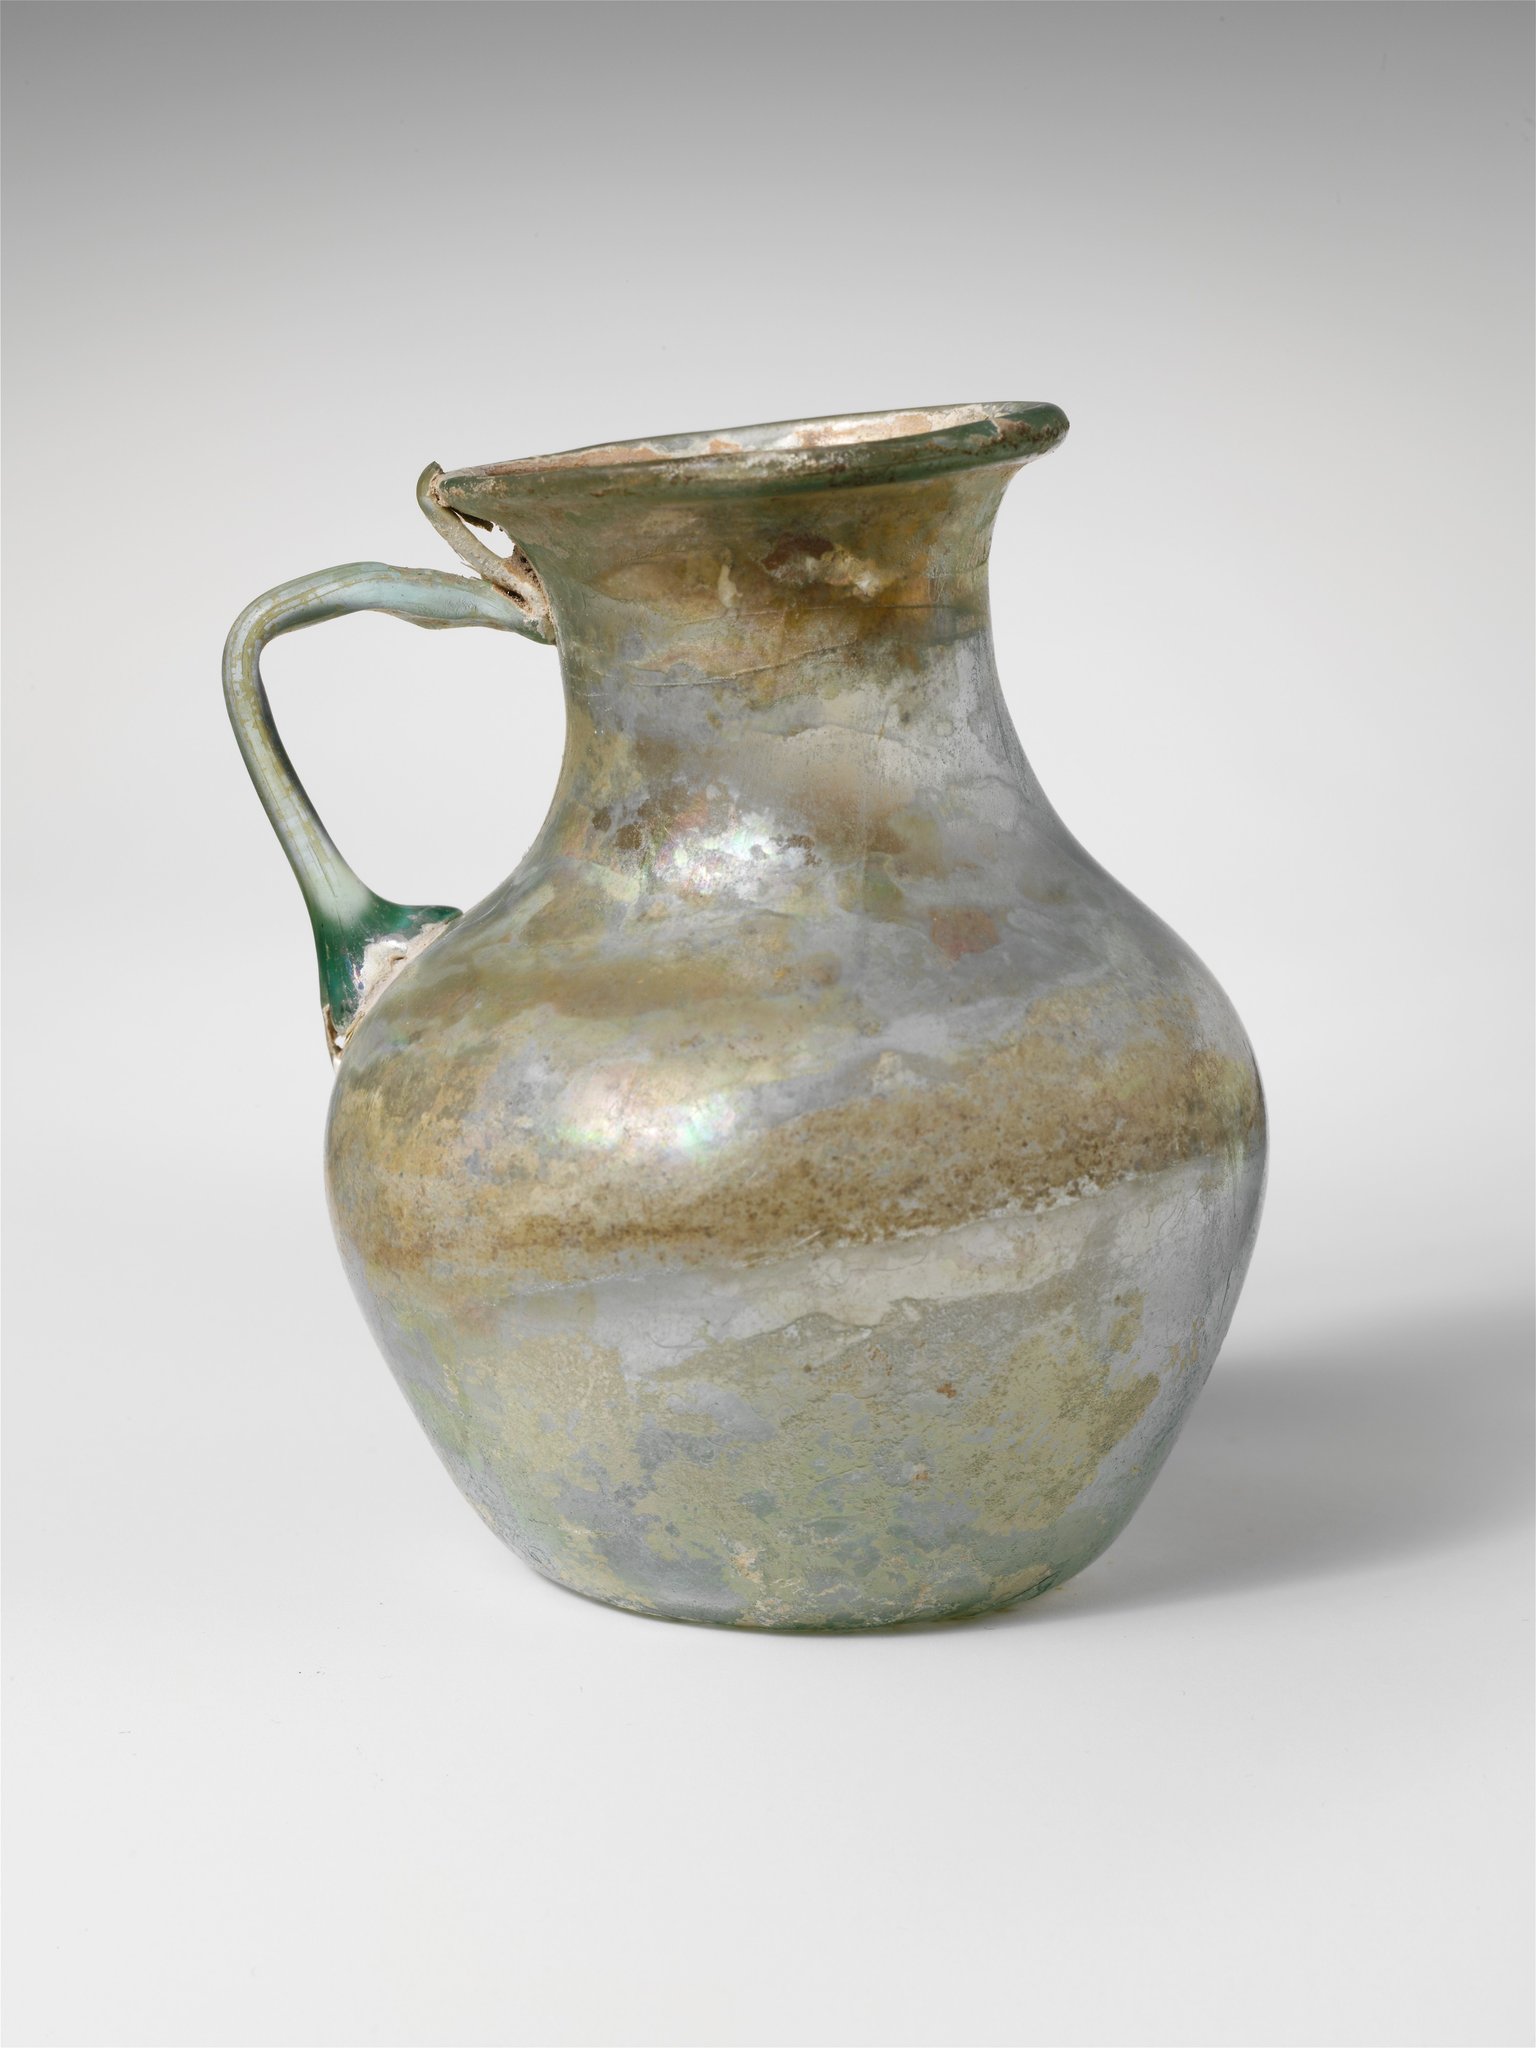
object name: jug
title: Glass jug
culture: roman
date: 1-300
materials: glass